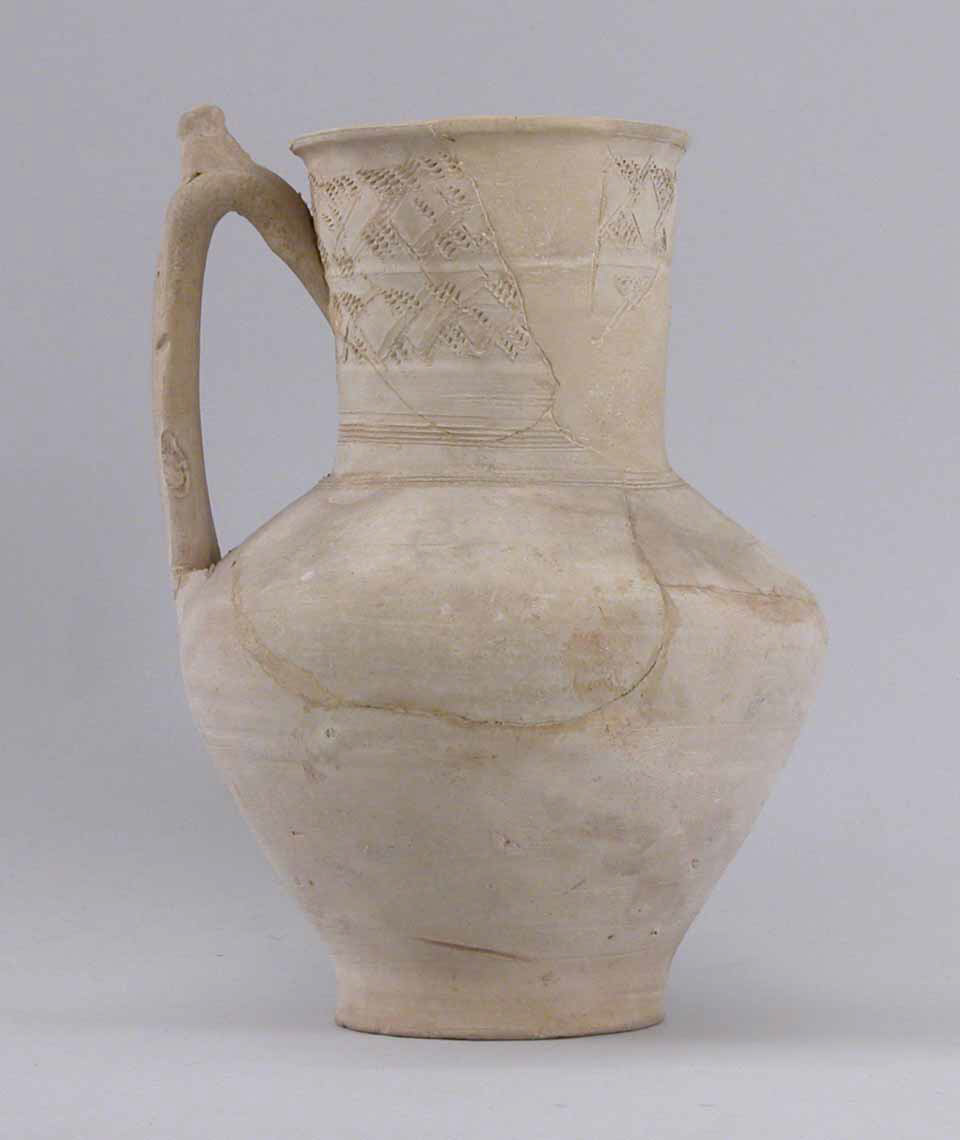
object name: jug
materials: earthenware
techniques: incising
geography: iran